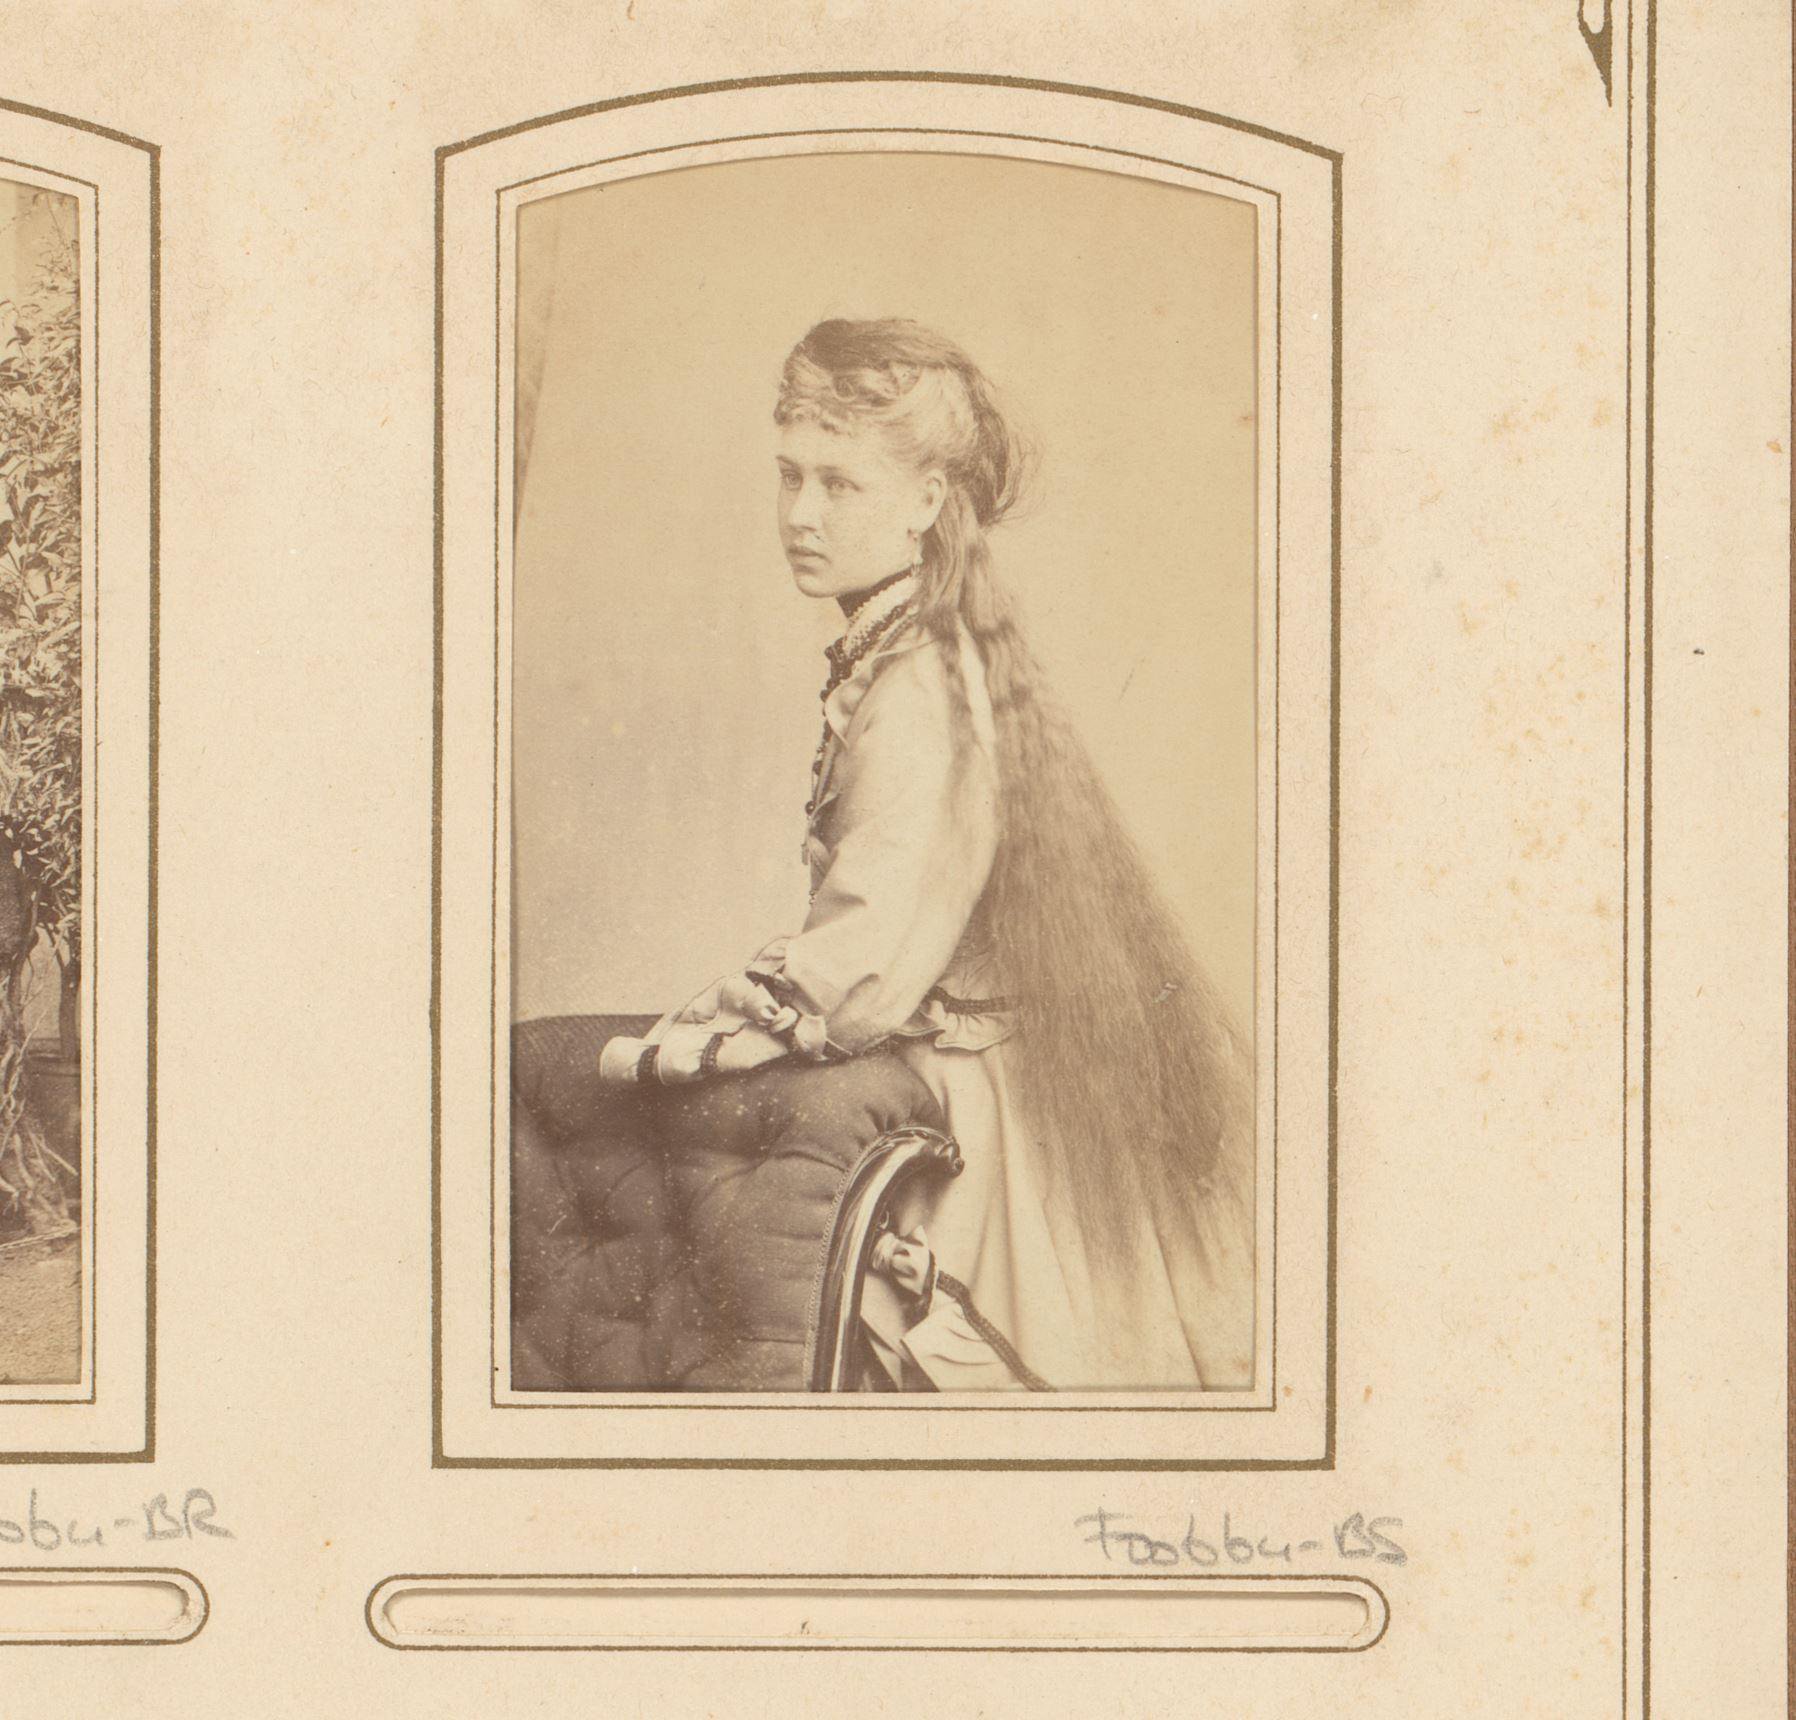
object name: photograph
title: Portret van Janny Macnab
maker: b.c. boake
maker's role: fotograaf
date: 1860-1880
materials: cardboard, photographic support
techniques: albumen print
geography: sydney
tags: historical persons - bb - woman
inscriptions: annotation: ‘To Mw. Van Braam/ with kind [...]/ Janny Macnab’